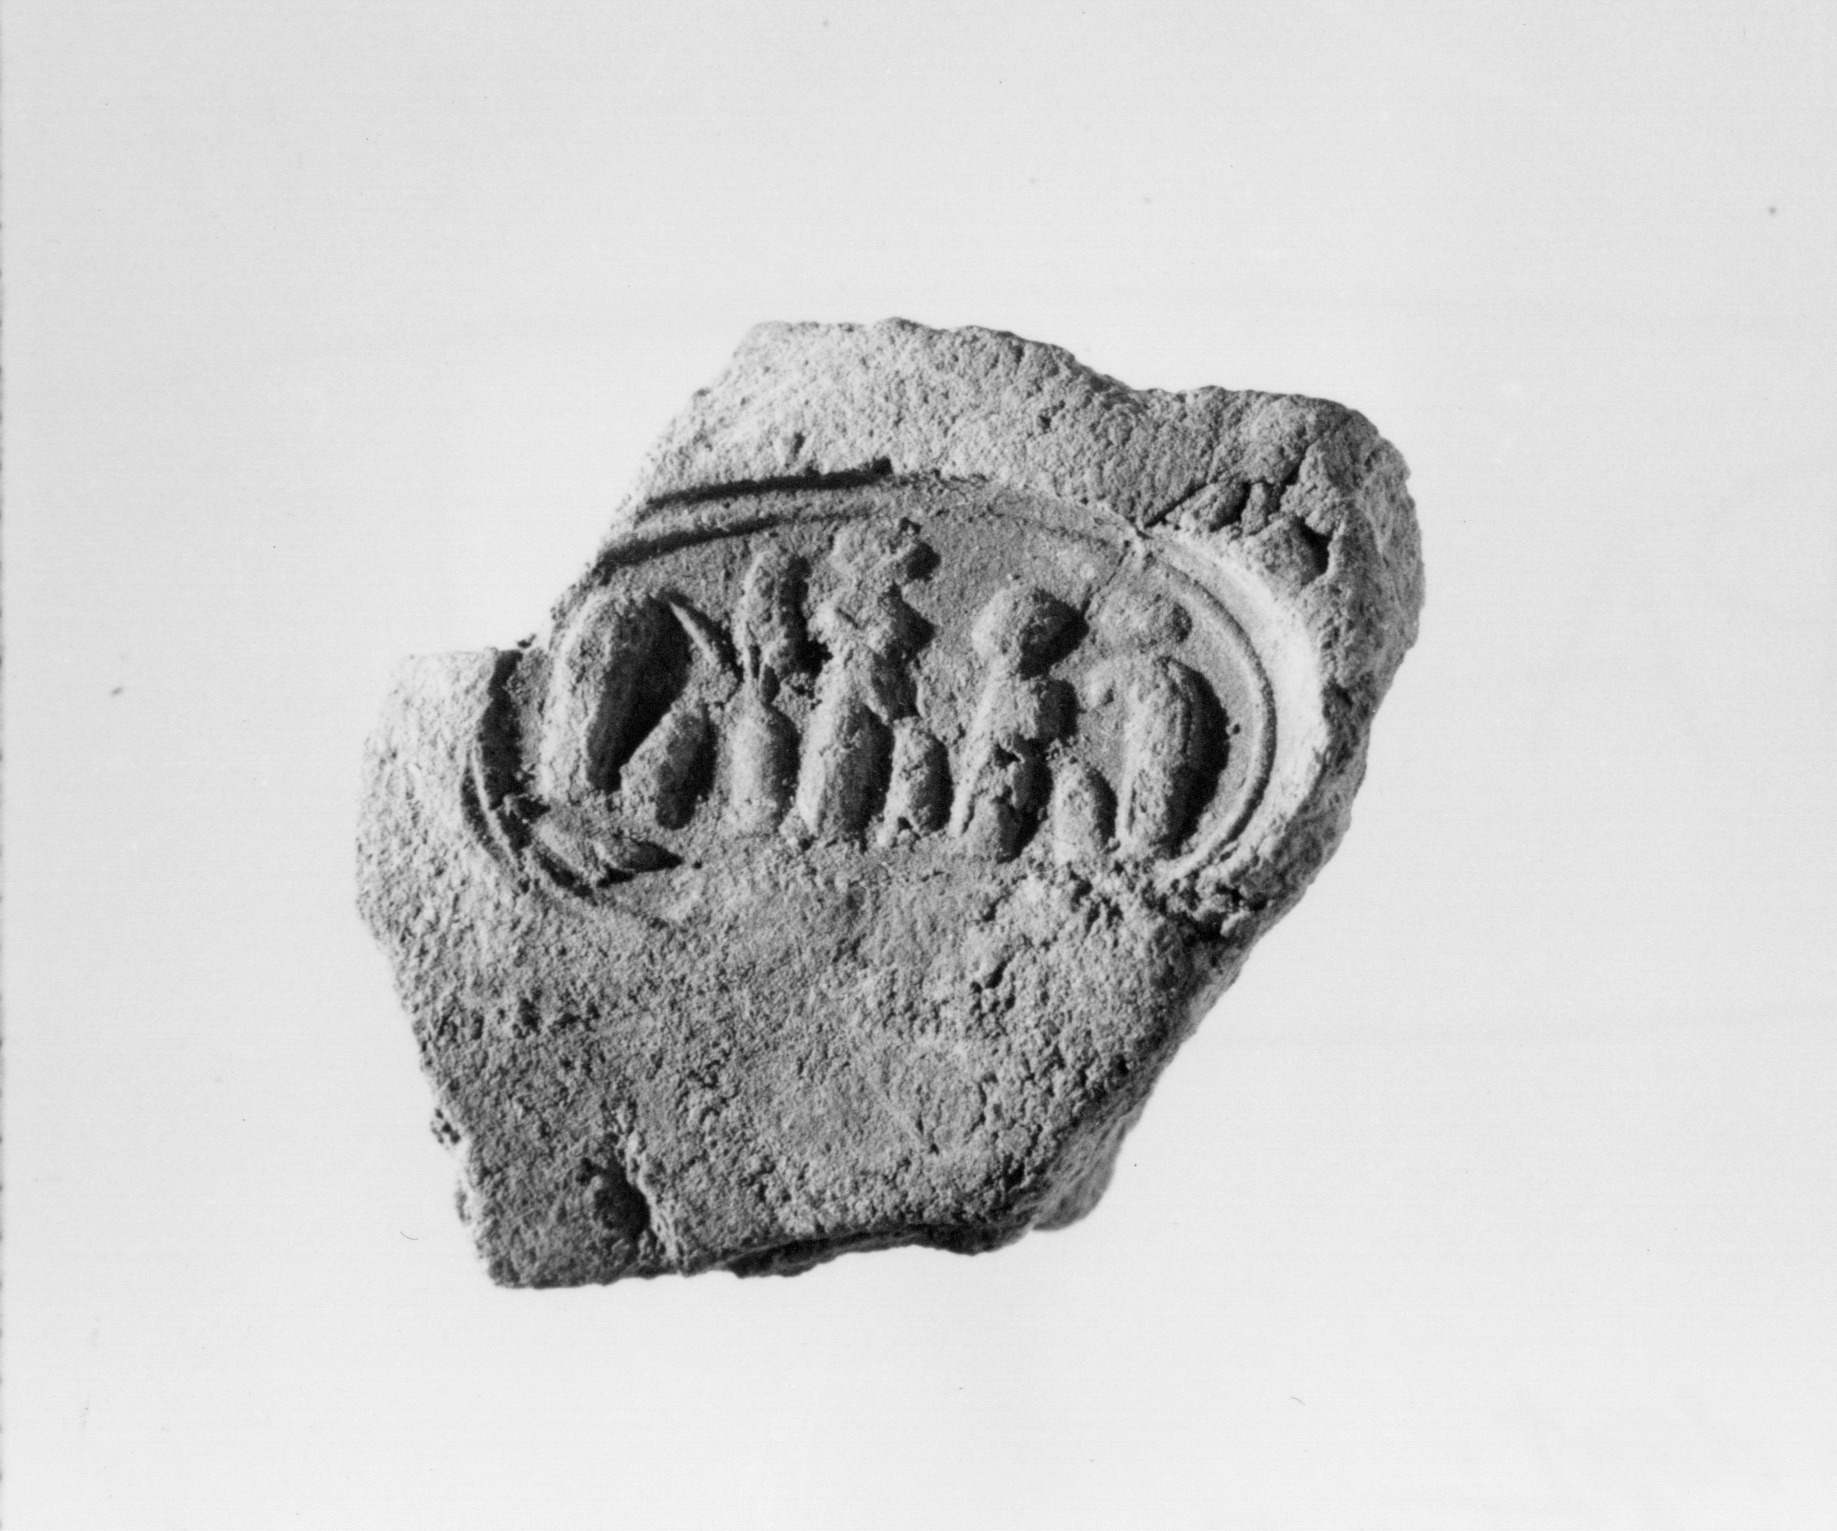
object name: sealing, nebmaatre, amenhotep iii, thoth, ptah, re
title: Document Sealing With the Throne Name of Amenhotep III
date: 1390-1352 BCE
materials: mud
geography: egypt